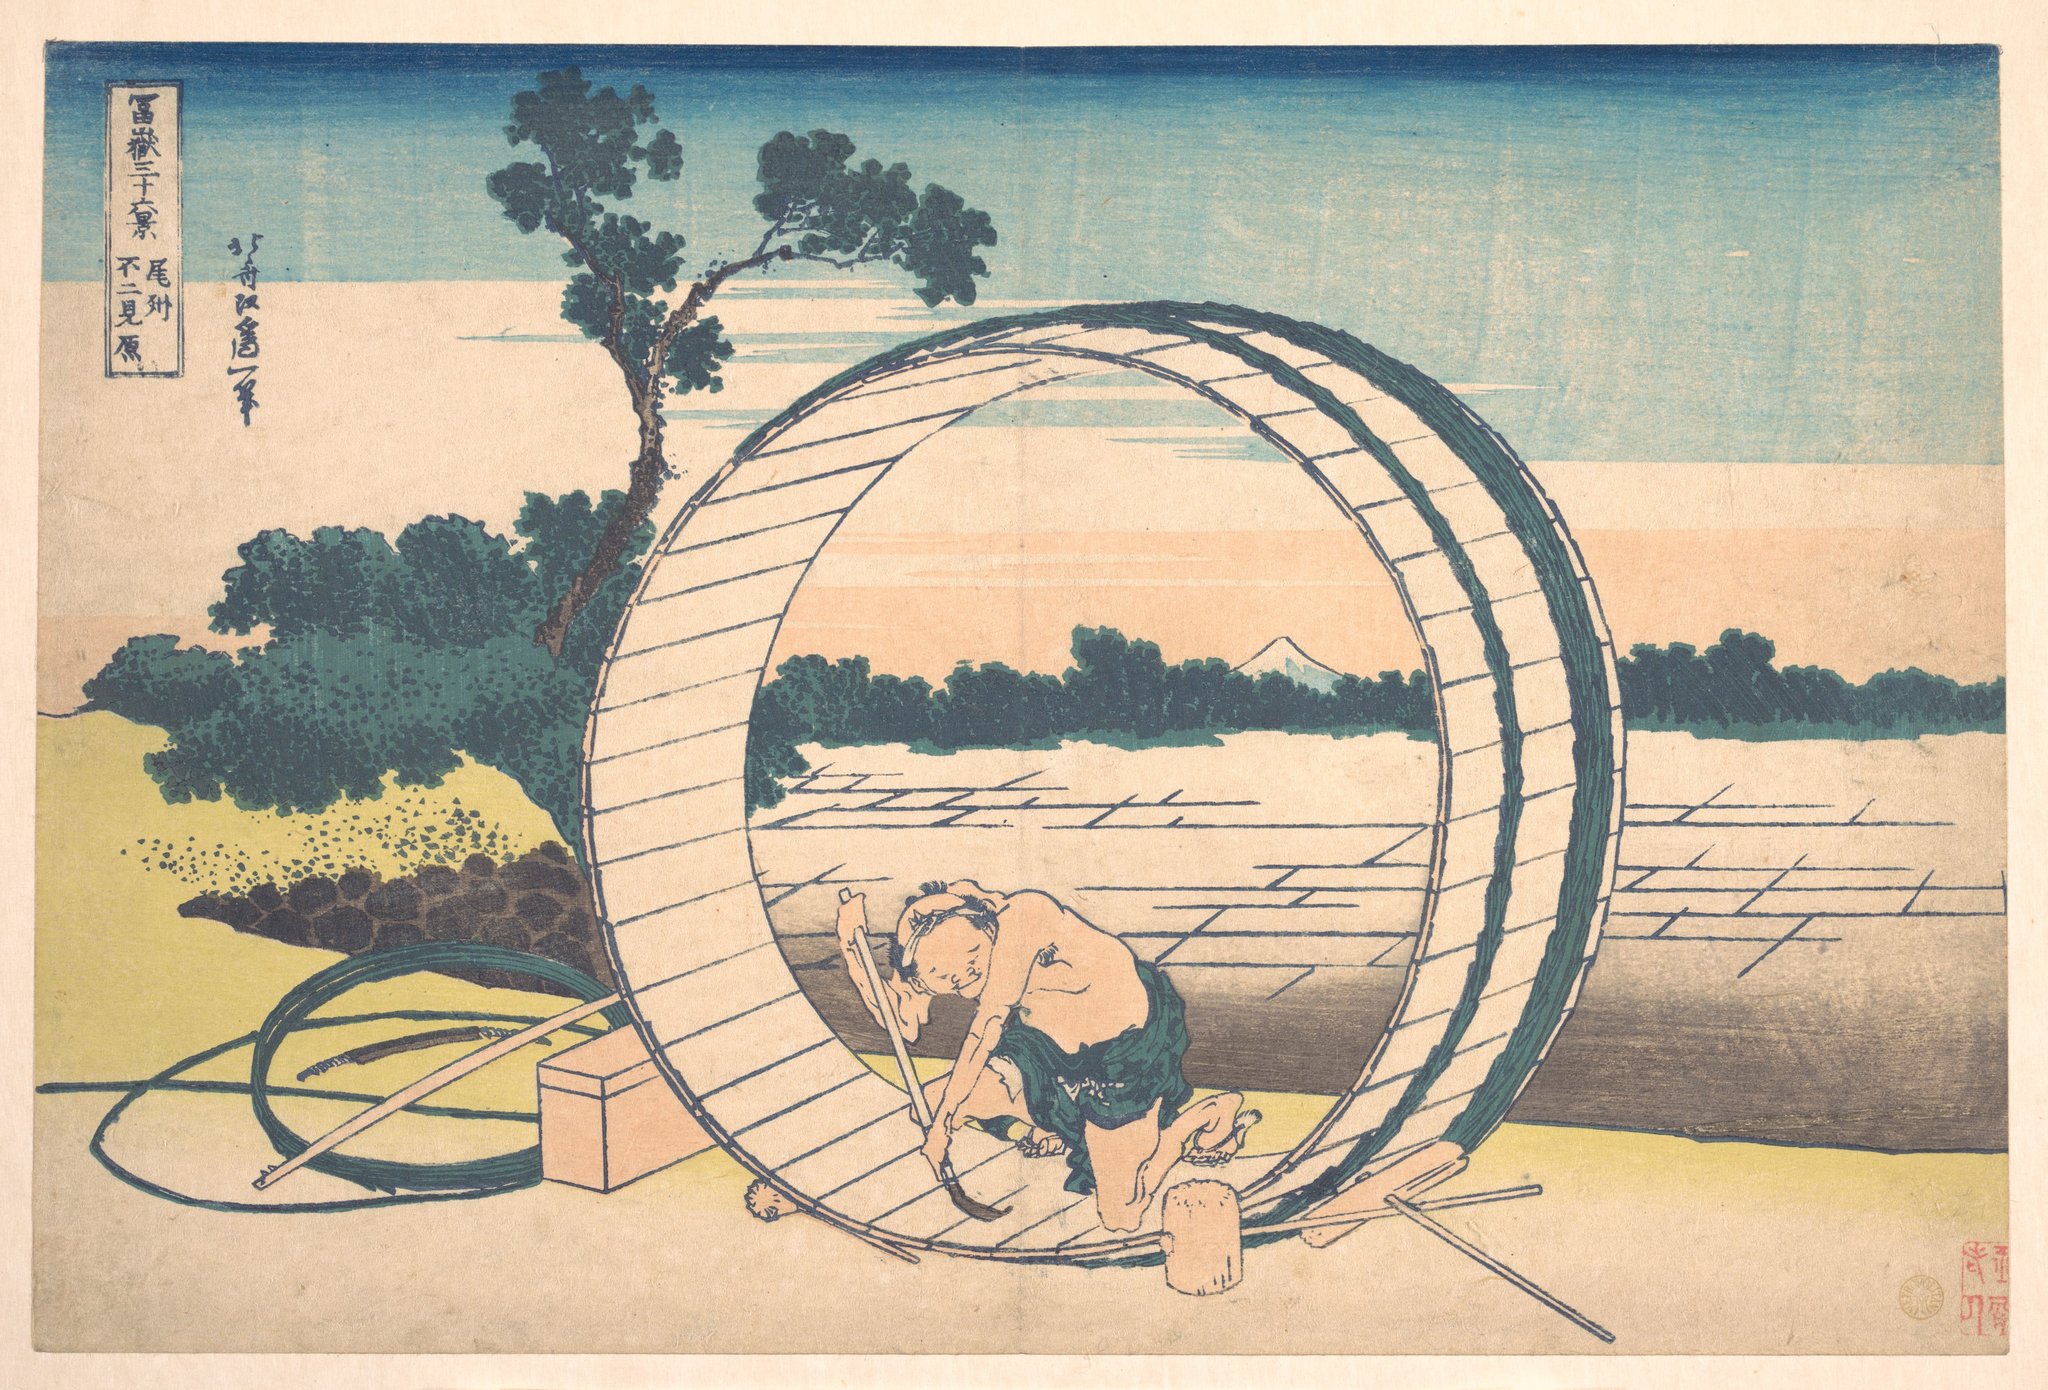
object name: woodblock print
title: Fujimigahara in Owari Province (Bishū Fujimigahara), from the series Thirty-six Views of Mount Fuji (Fugaku sanjūrokkei)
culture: japanese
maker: katsushika hokusai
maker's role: artist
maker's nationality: japanese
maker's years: 1760-1849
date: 1830-1832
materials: ink, paper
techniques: woodblock print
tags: men,trees,working